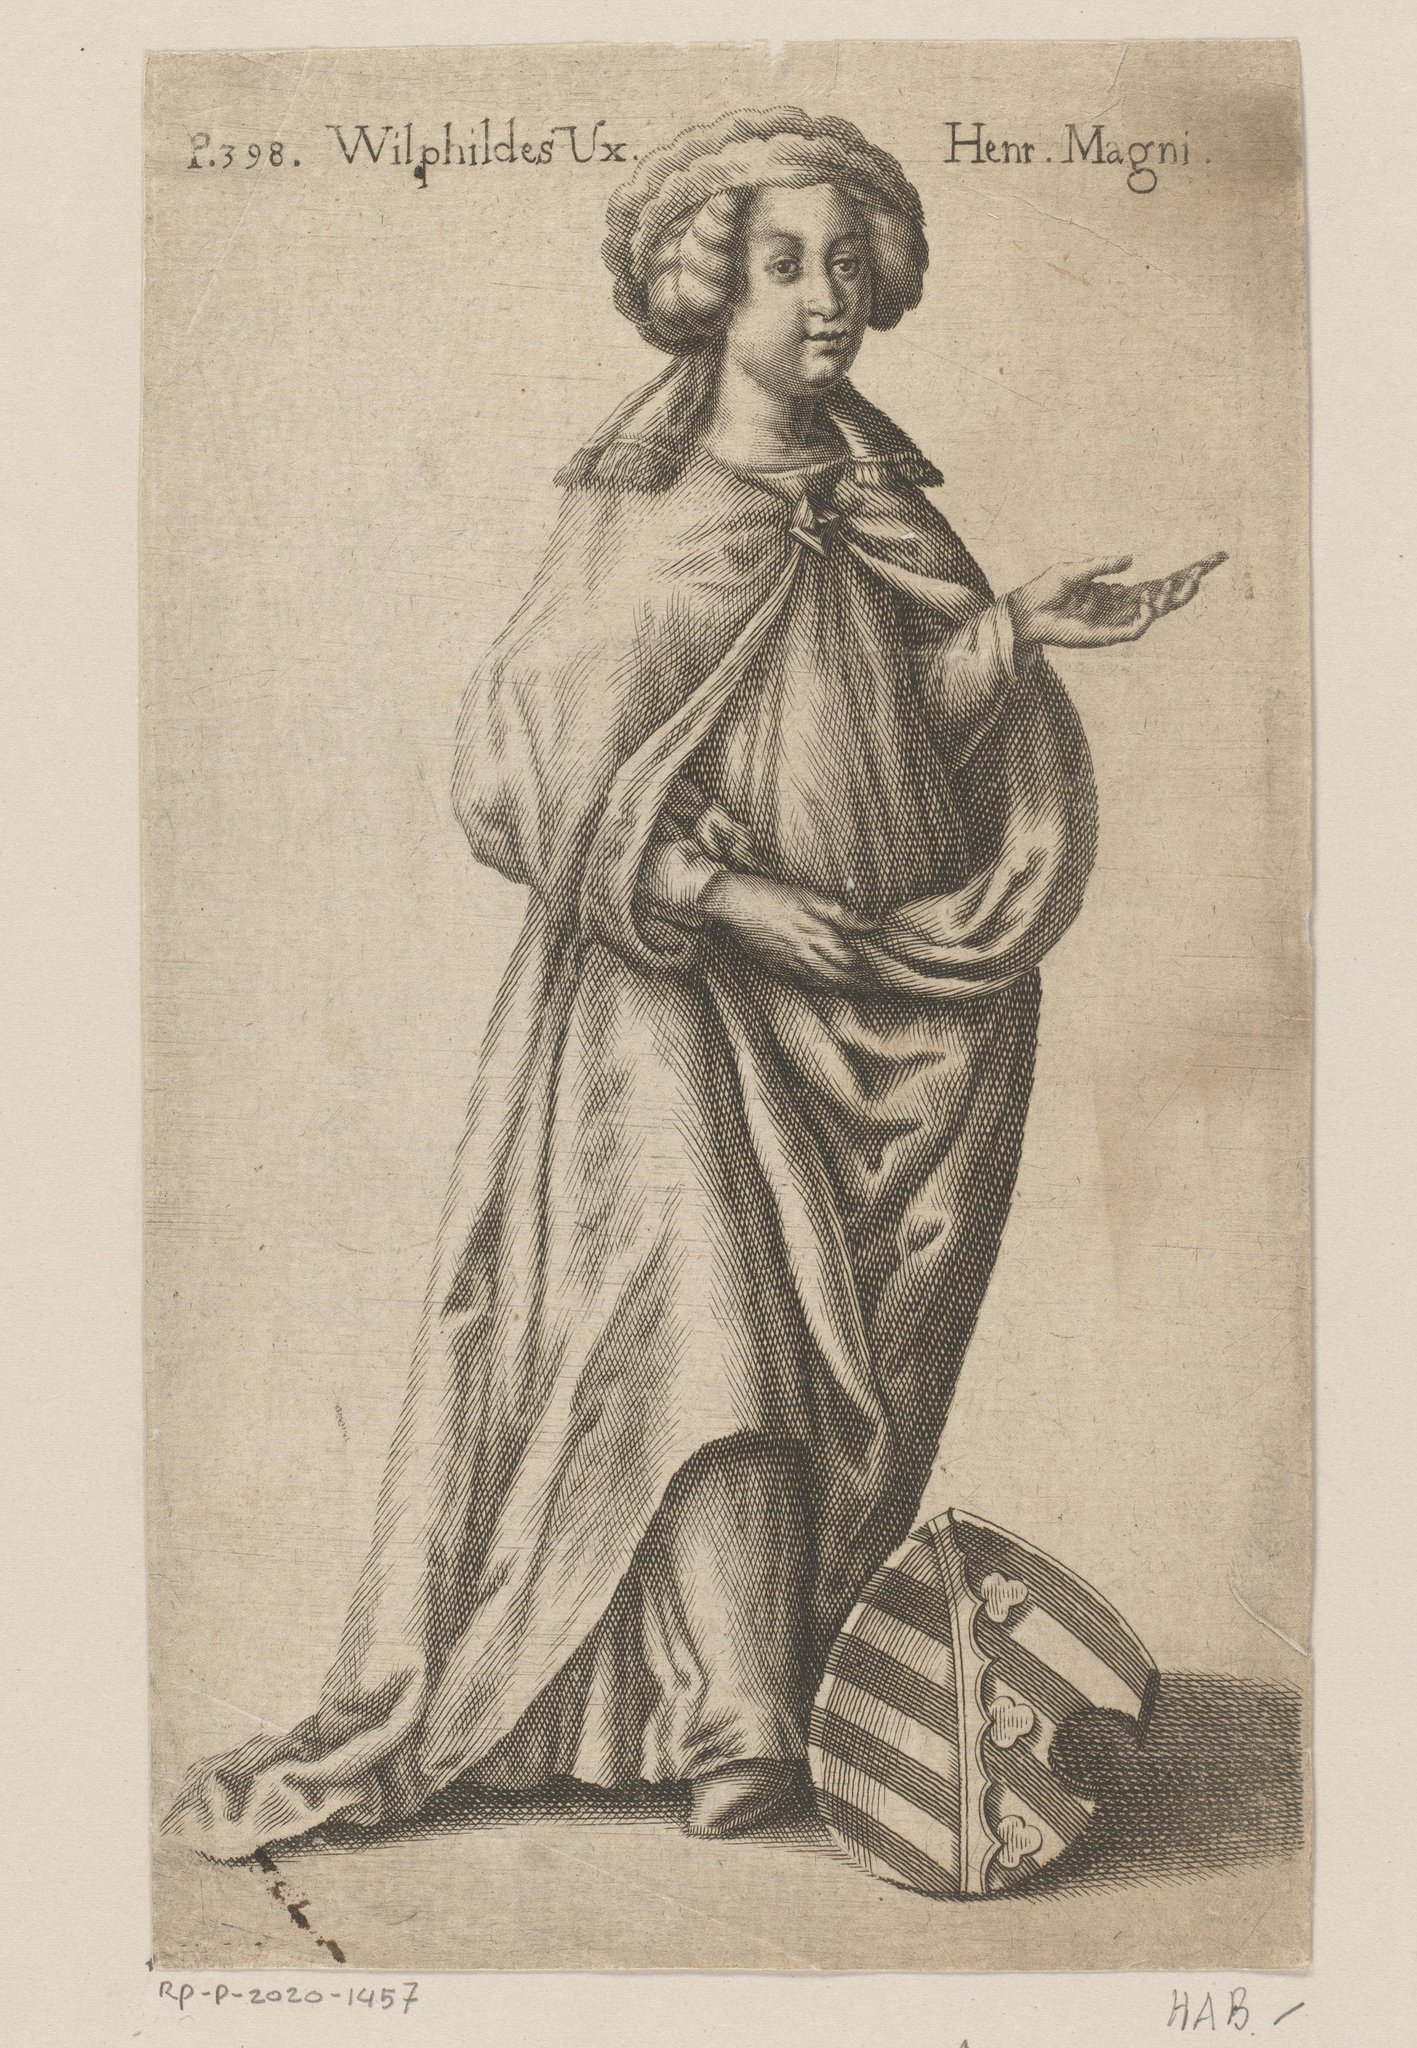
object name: print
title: Portret van Wulfhilde van Saksen, hertogin van Beieren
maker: Anonymous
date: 1550-1649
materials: paper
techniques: engraving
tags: historical persons, dress, gown, armorial bearing, heraldry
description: Staand met aan haar voeten een wapenschild. Rechtsboven genummerd: p.398.